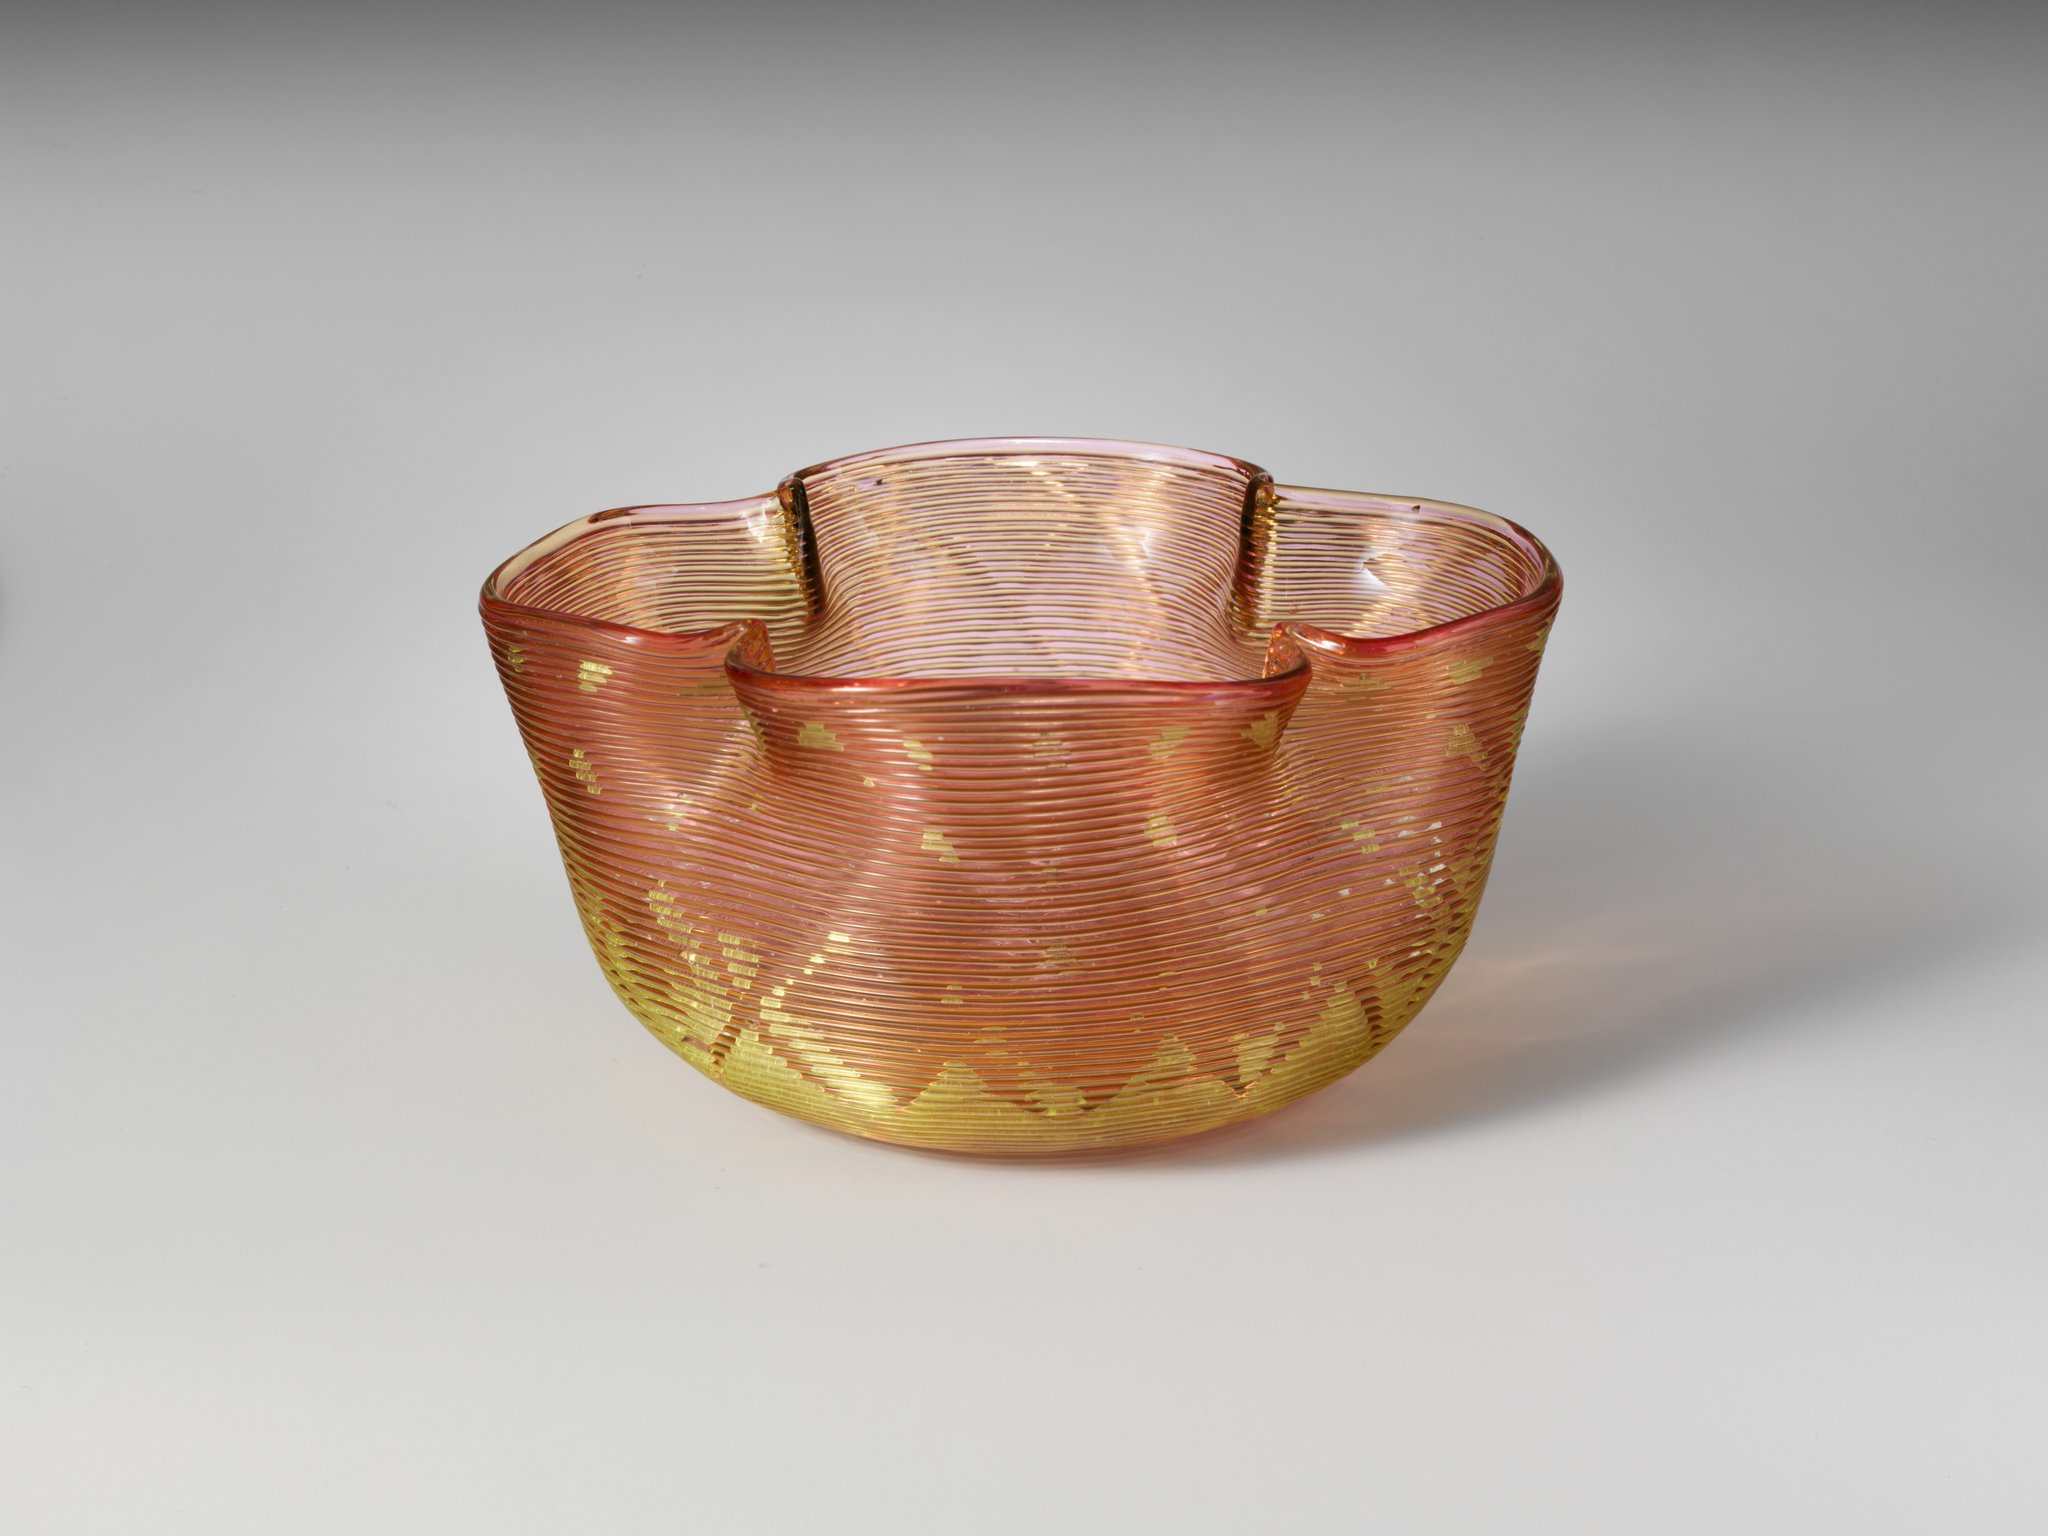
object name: finger bowl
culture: american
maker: boston & sandwich glass company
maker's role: maker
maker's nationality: american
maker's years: 1825-1888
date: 1880-1888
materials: amber, glass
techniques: glassblowing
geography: united states